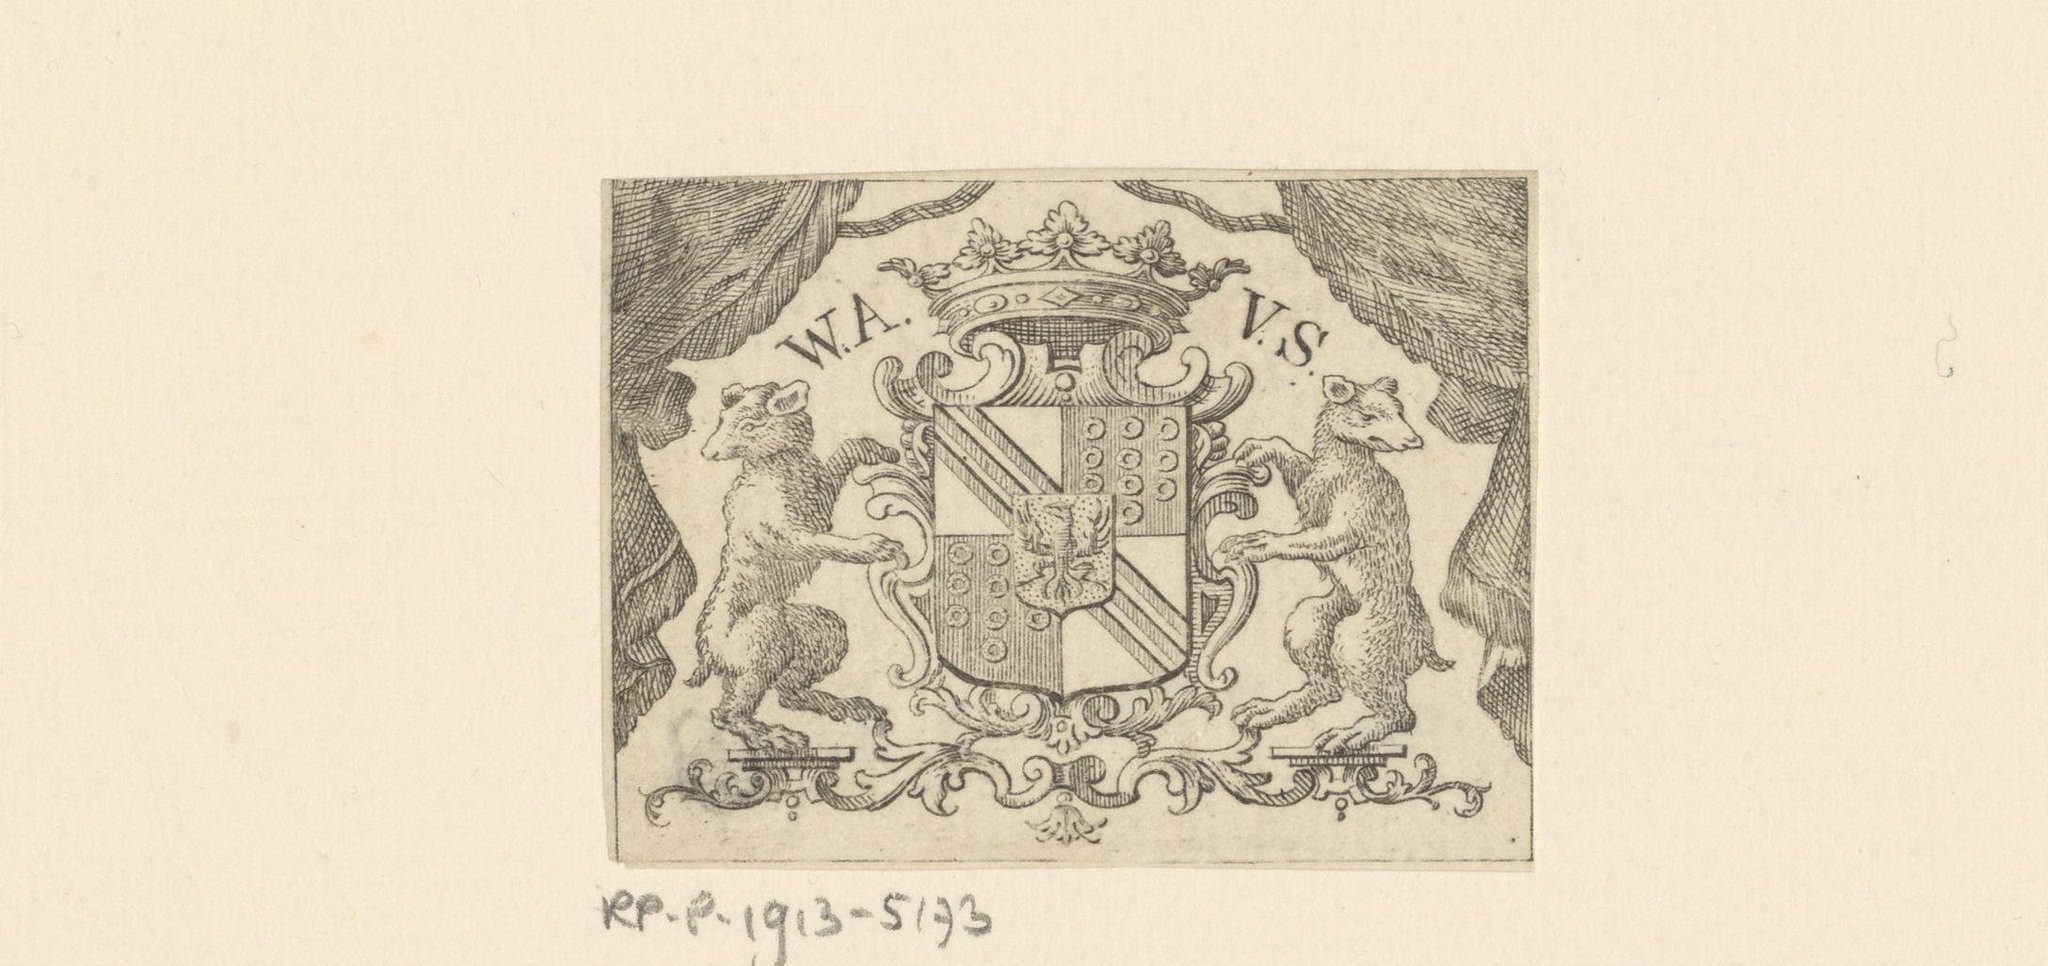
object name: bookplate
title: Ex libris van W.A.V.S.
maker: Anonymous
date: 1765-1817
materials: paper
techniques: etching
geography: netherlands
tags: the hague, politician, beasts of prey, predatory animals: bear, armorial bearing, heraldry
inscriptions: collector's mark: Lugt 2760, collector's mark: Lugt 2233